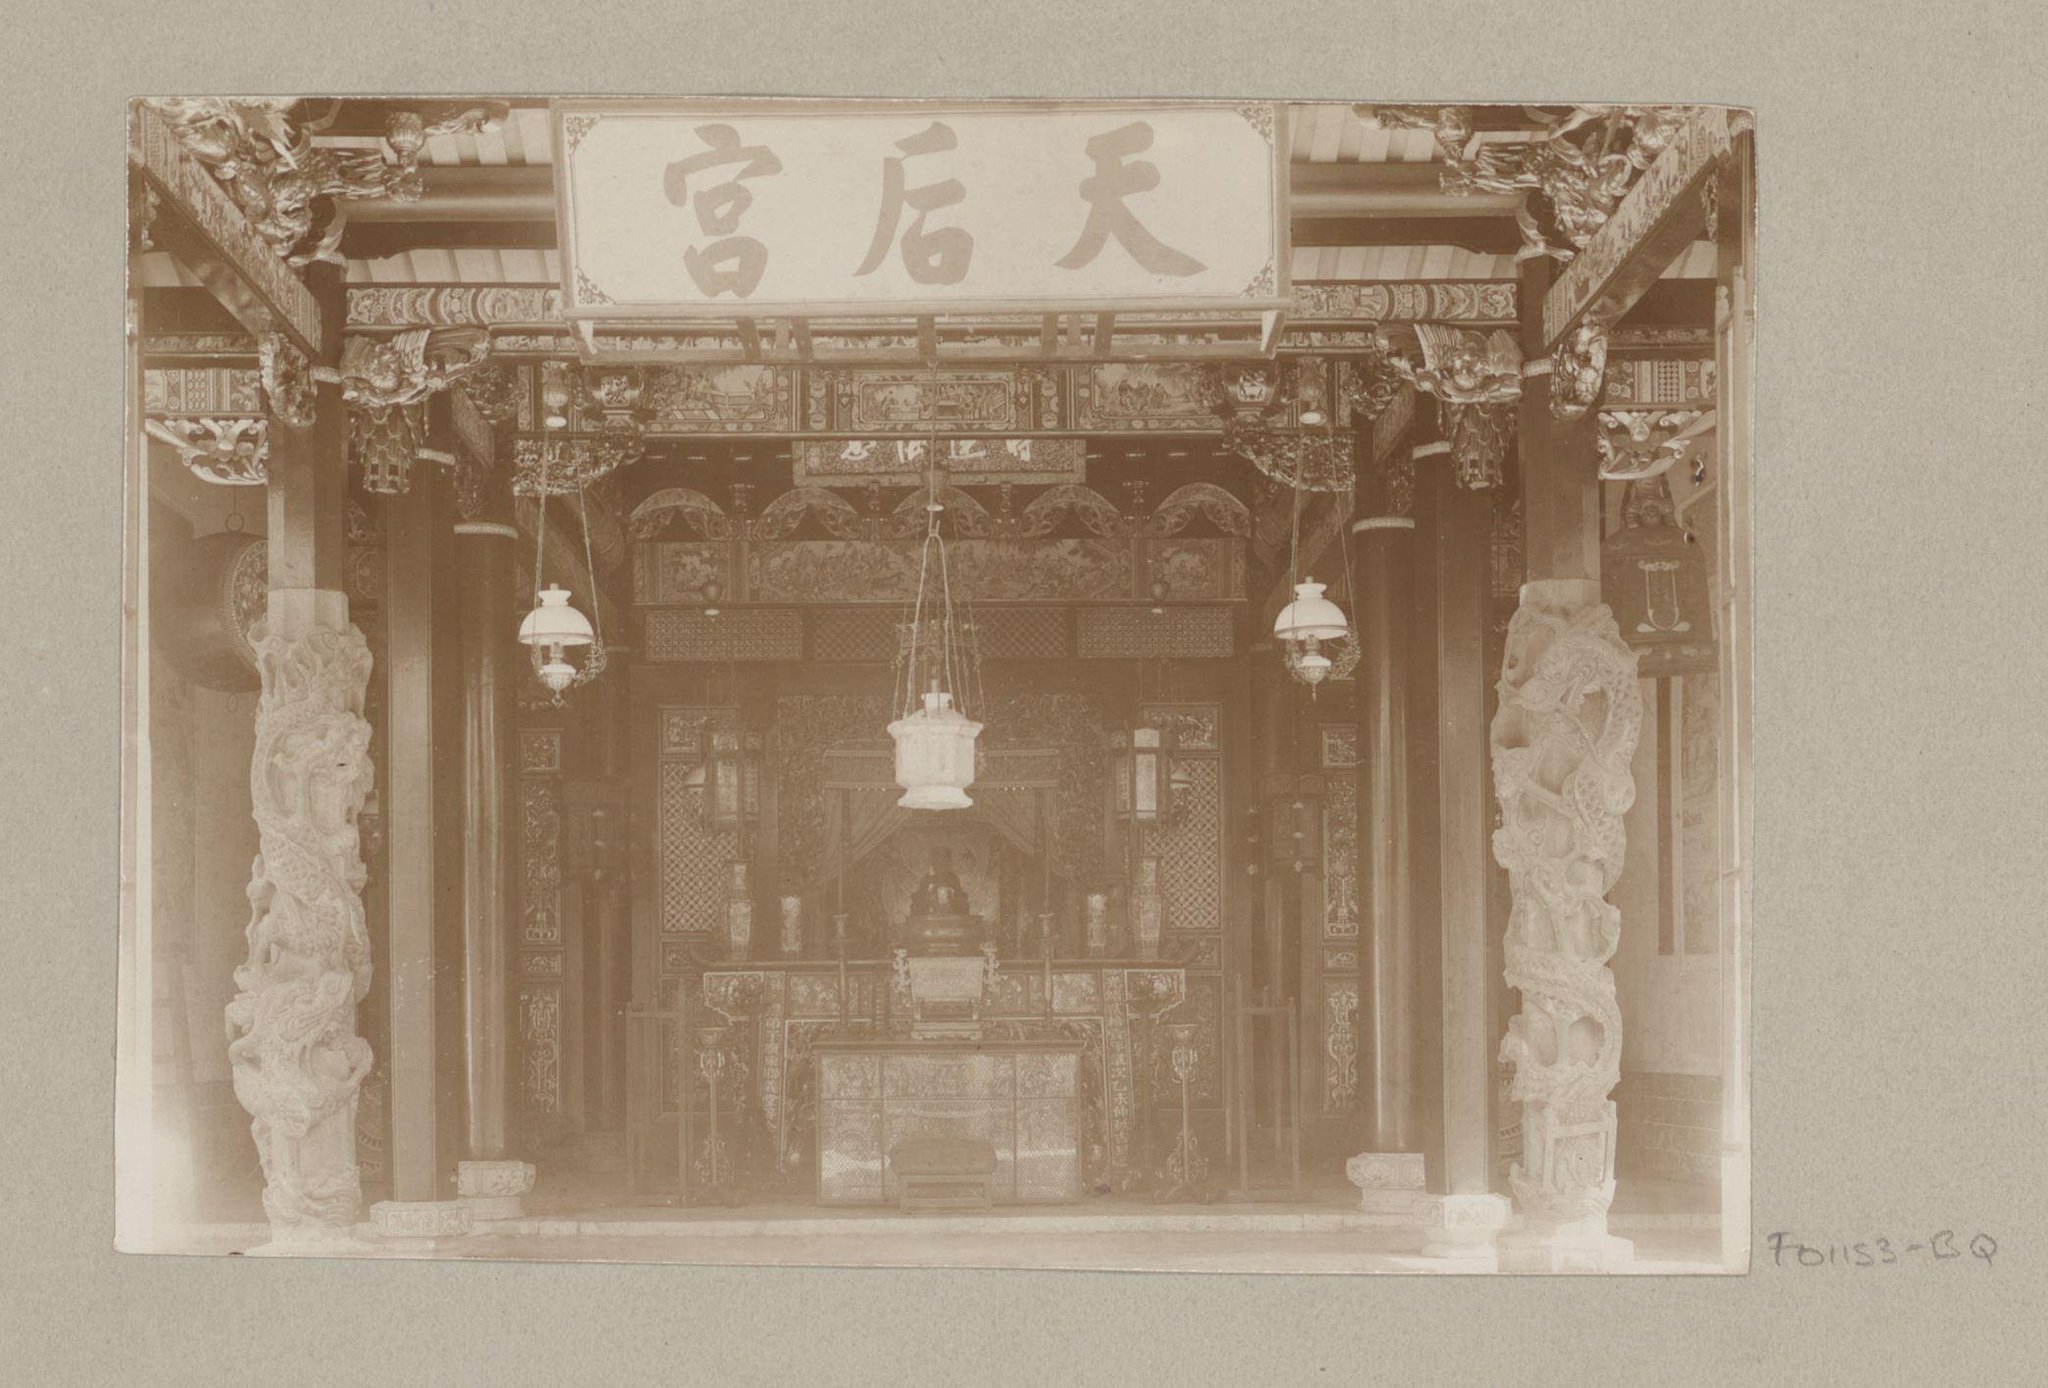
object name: photograph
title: Interieur van een tempel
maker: Anonymous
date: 1880-1900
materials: photographic support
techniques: collodion silver print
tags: altar ~ hinduism, buddhism, jainism, dutch east indies, the